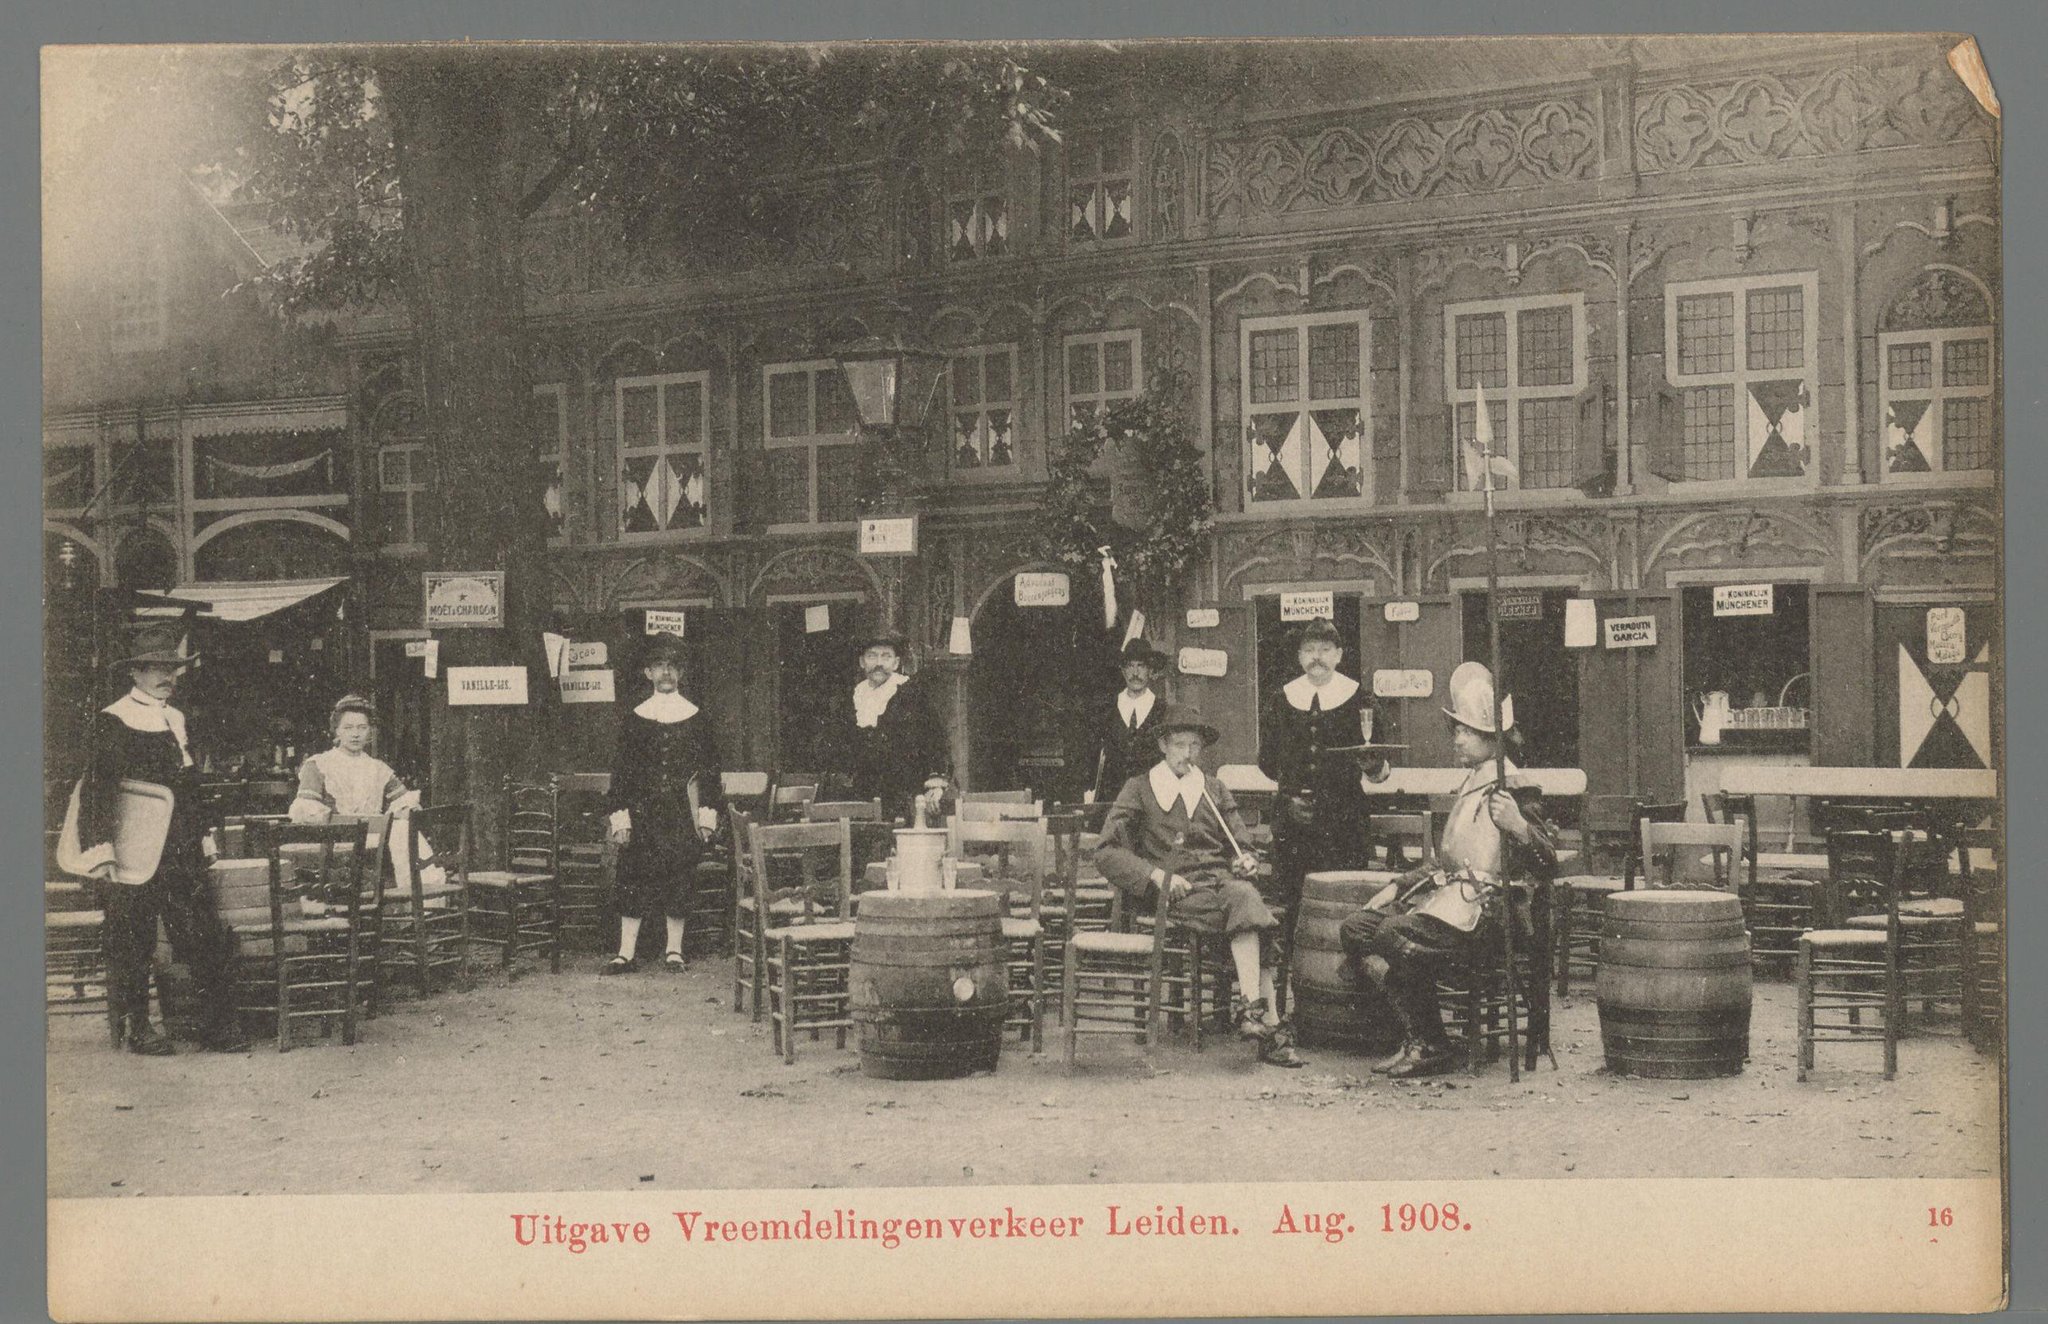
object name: ansichtkaart, prentbriefkaart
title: Mensen in kostuum voor een café tijdens de Oud-Hollandse feesten te Leiden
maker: Anonymous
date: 1908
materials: cardboard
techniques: photograph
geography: leiden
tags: wooden container: barrel, cask, bucket, dress-up party, inn, coffee-house, public house, etc., chair, festivities, leiden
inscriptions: date